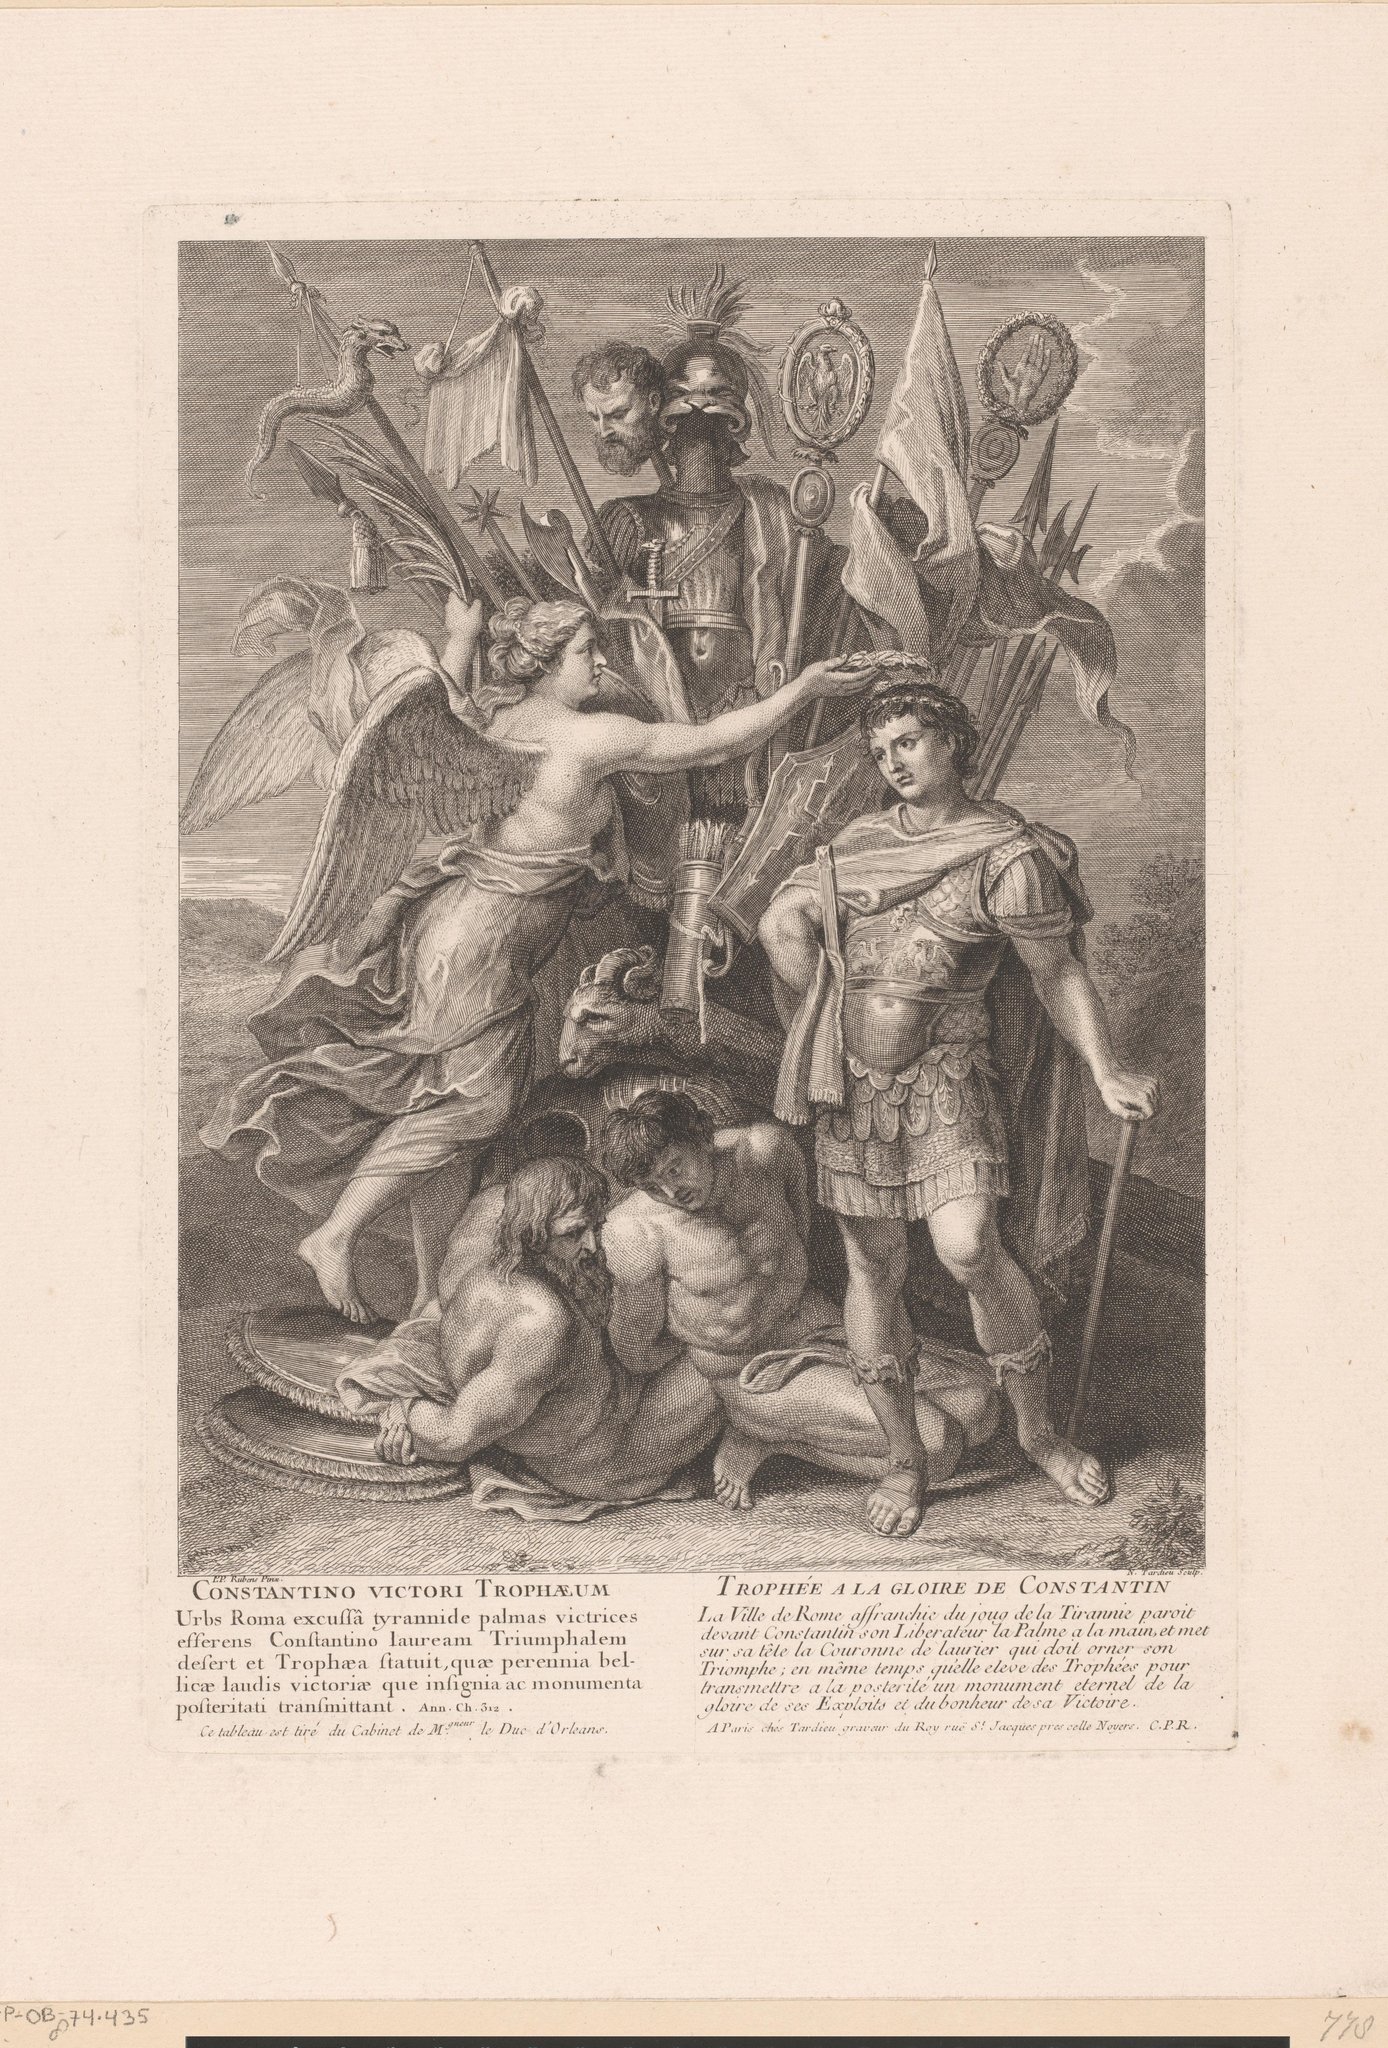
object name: print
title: Keizer Constantijn ontvangt de eretrofee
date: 1684-1749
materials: paper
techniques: engraving, etching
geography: paris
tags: crowning the victor with laurel, the roman emperor constantine the great; possible attributes: crown, sceptre, standard (labarum) with chi-rho monogram or cross, rome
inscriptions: collector's mark: Lugt 240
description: Een personificatie van de stad Rome kroont keizer Constantijn de Grote met een laurierkrans.